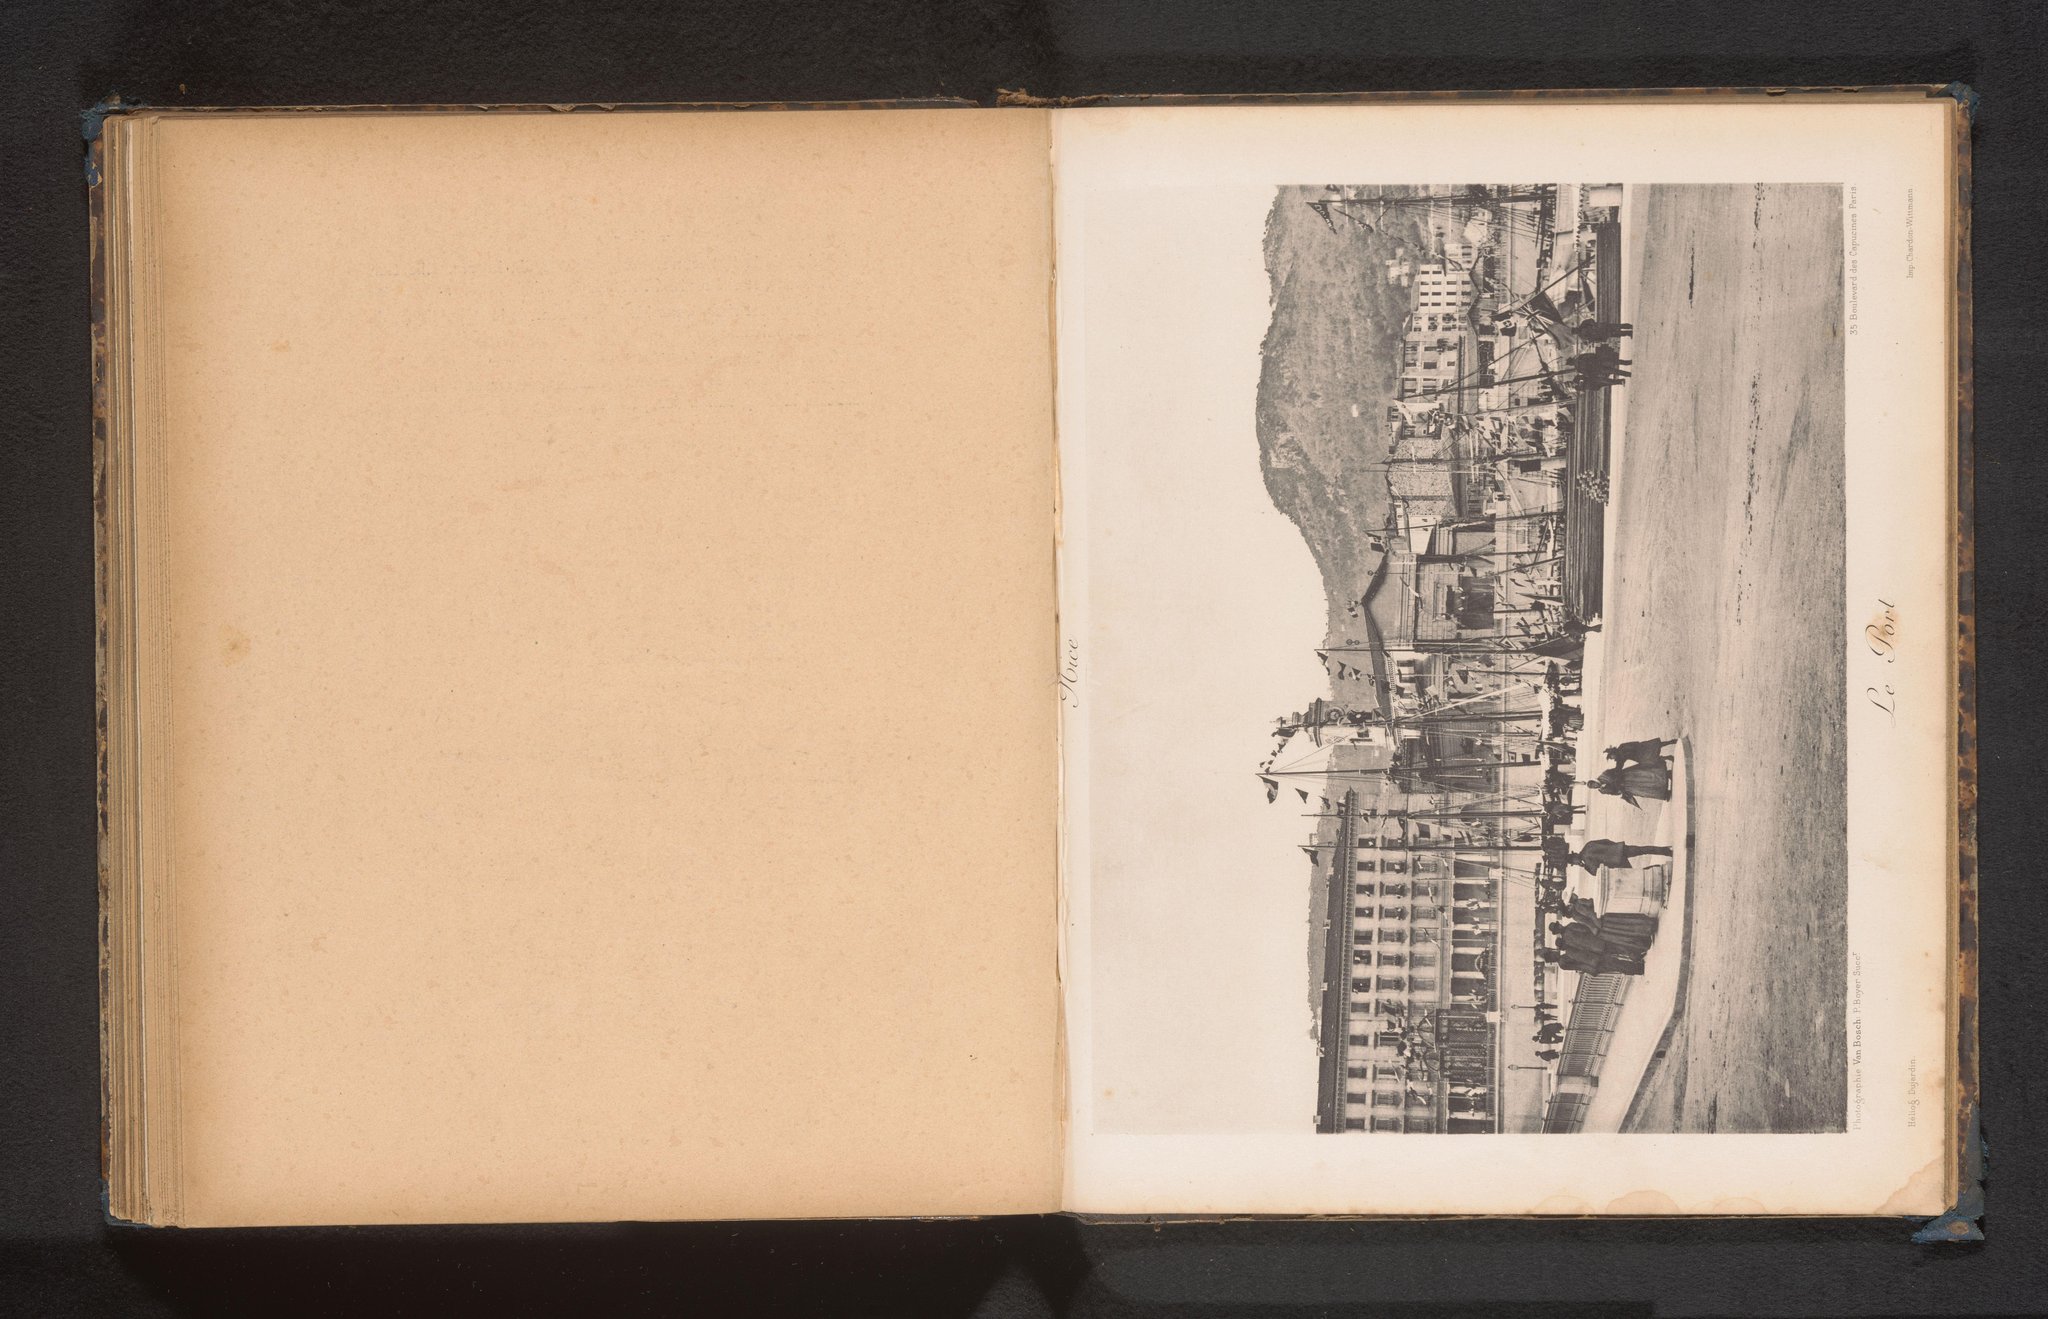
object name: photomechanical print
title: Le port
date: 1888-1890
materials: paper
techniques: photoaquatint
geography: nice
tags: harbour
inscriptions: inscription: ‘35 Boulevard des Capucines Paris’, inscription: ‘Nice’